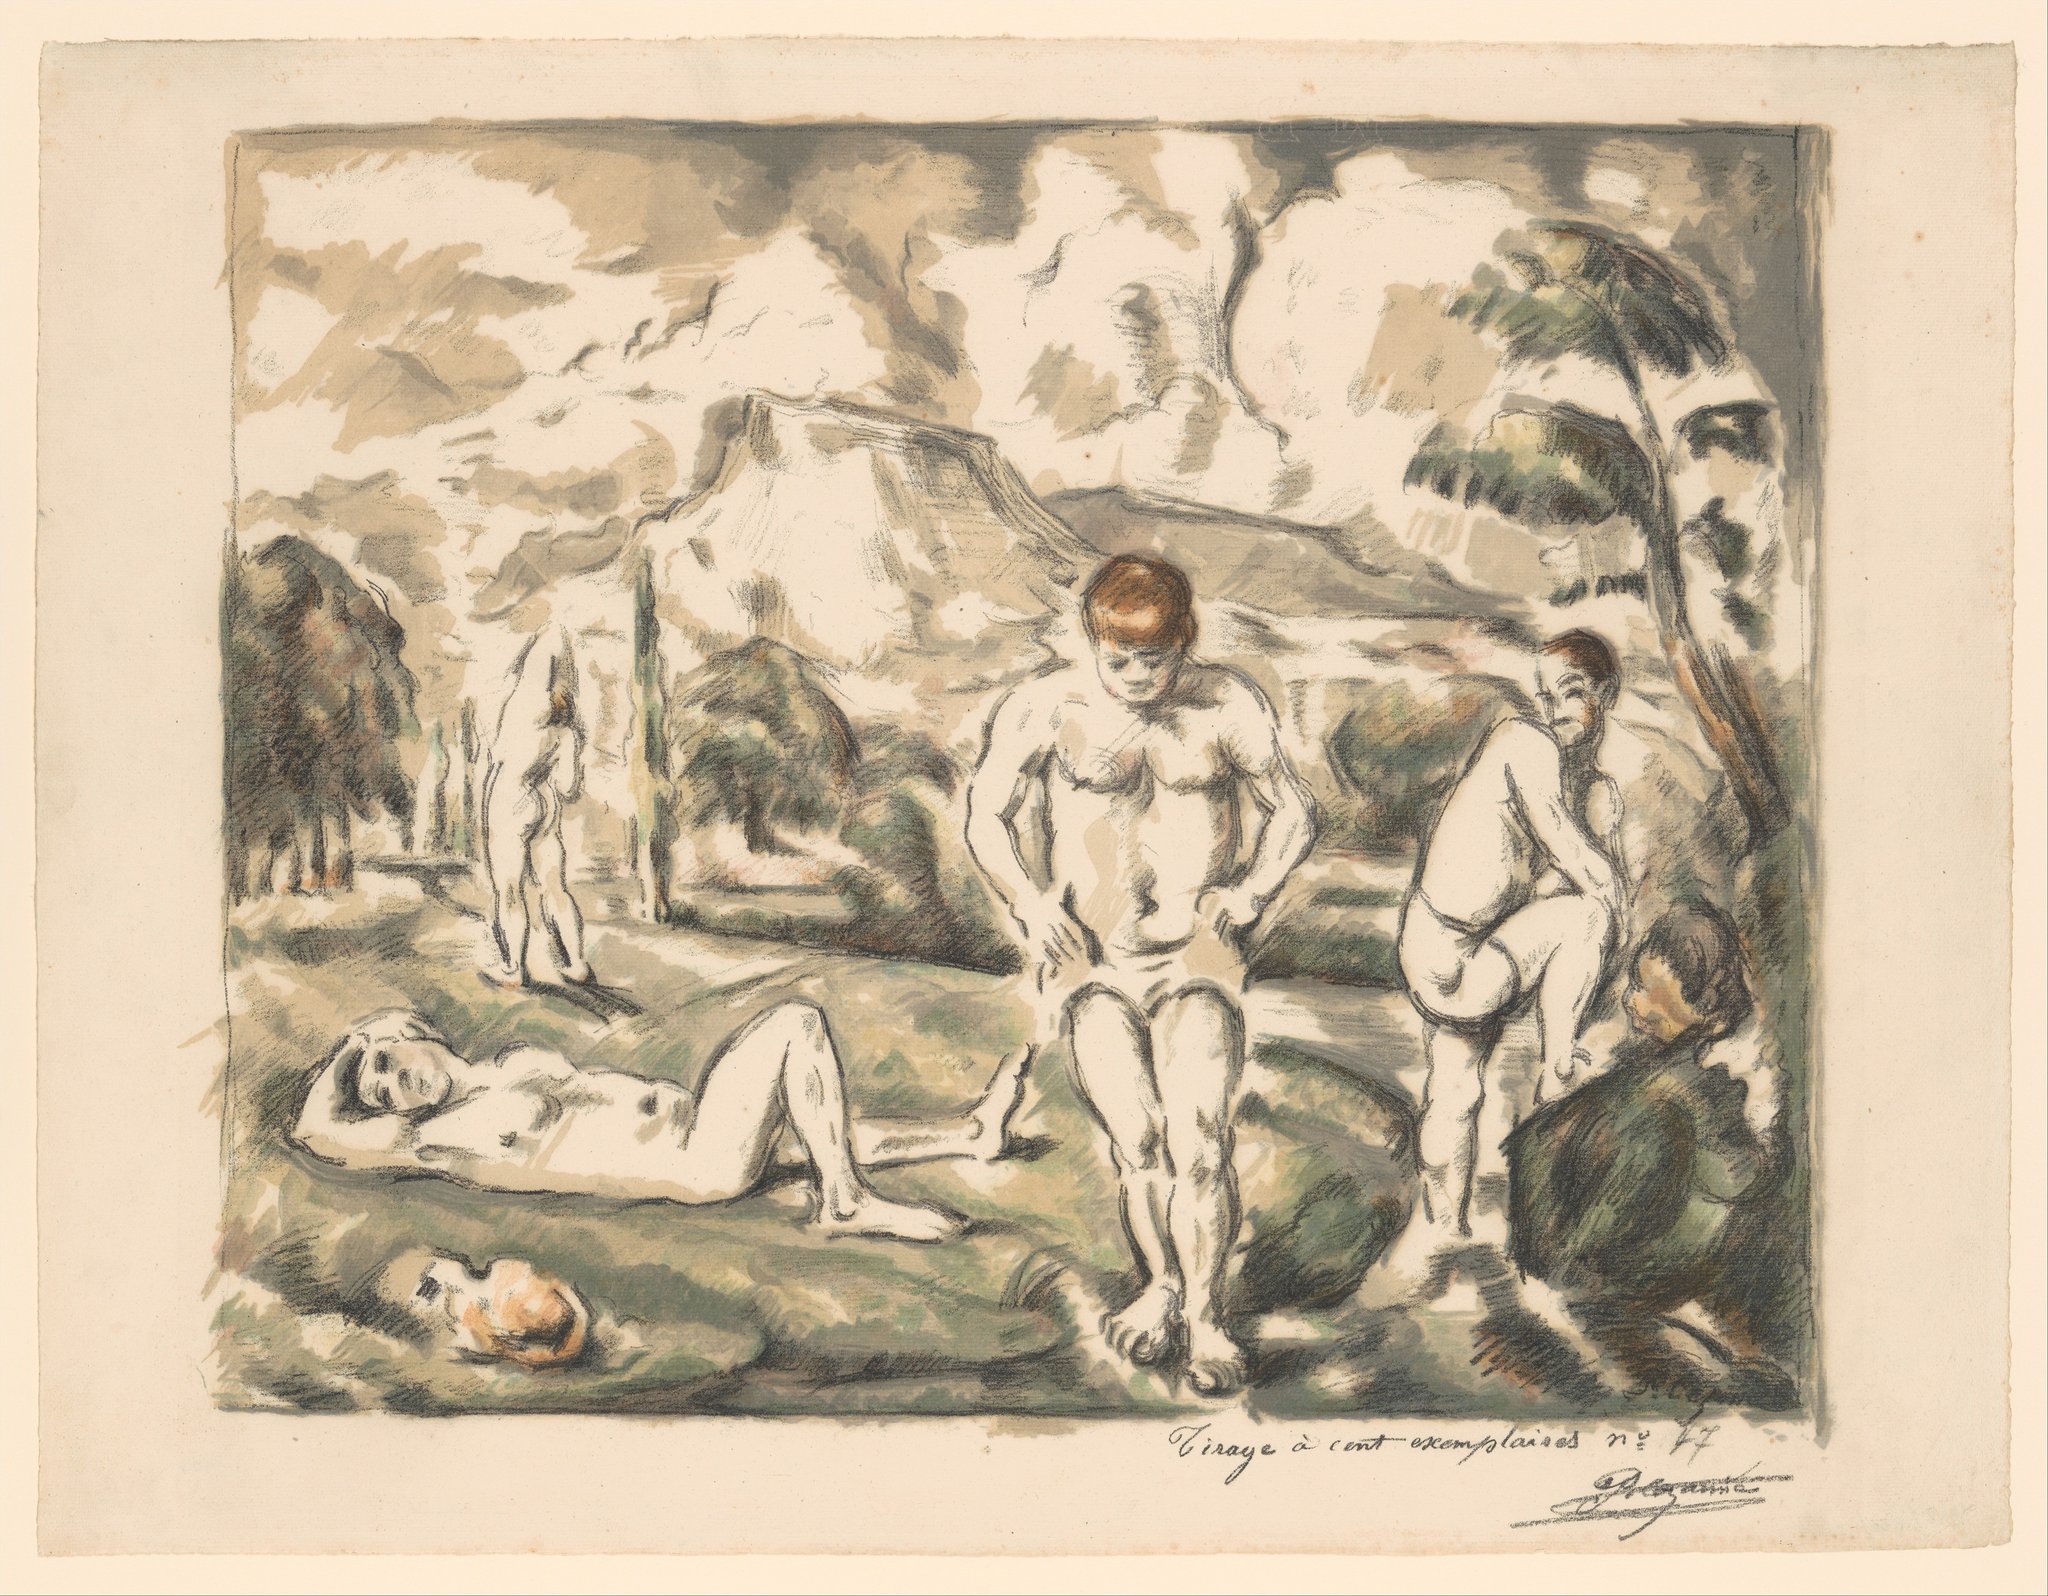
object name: print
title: The Large Bathers (Les Baigneurs)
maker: paul cézanne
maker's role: artist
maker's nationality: french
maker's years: 1839-1906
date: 1898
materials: paper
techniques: lithograph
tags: male nudes,mountains,landscapes,trees,bathing